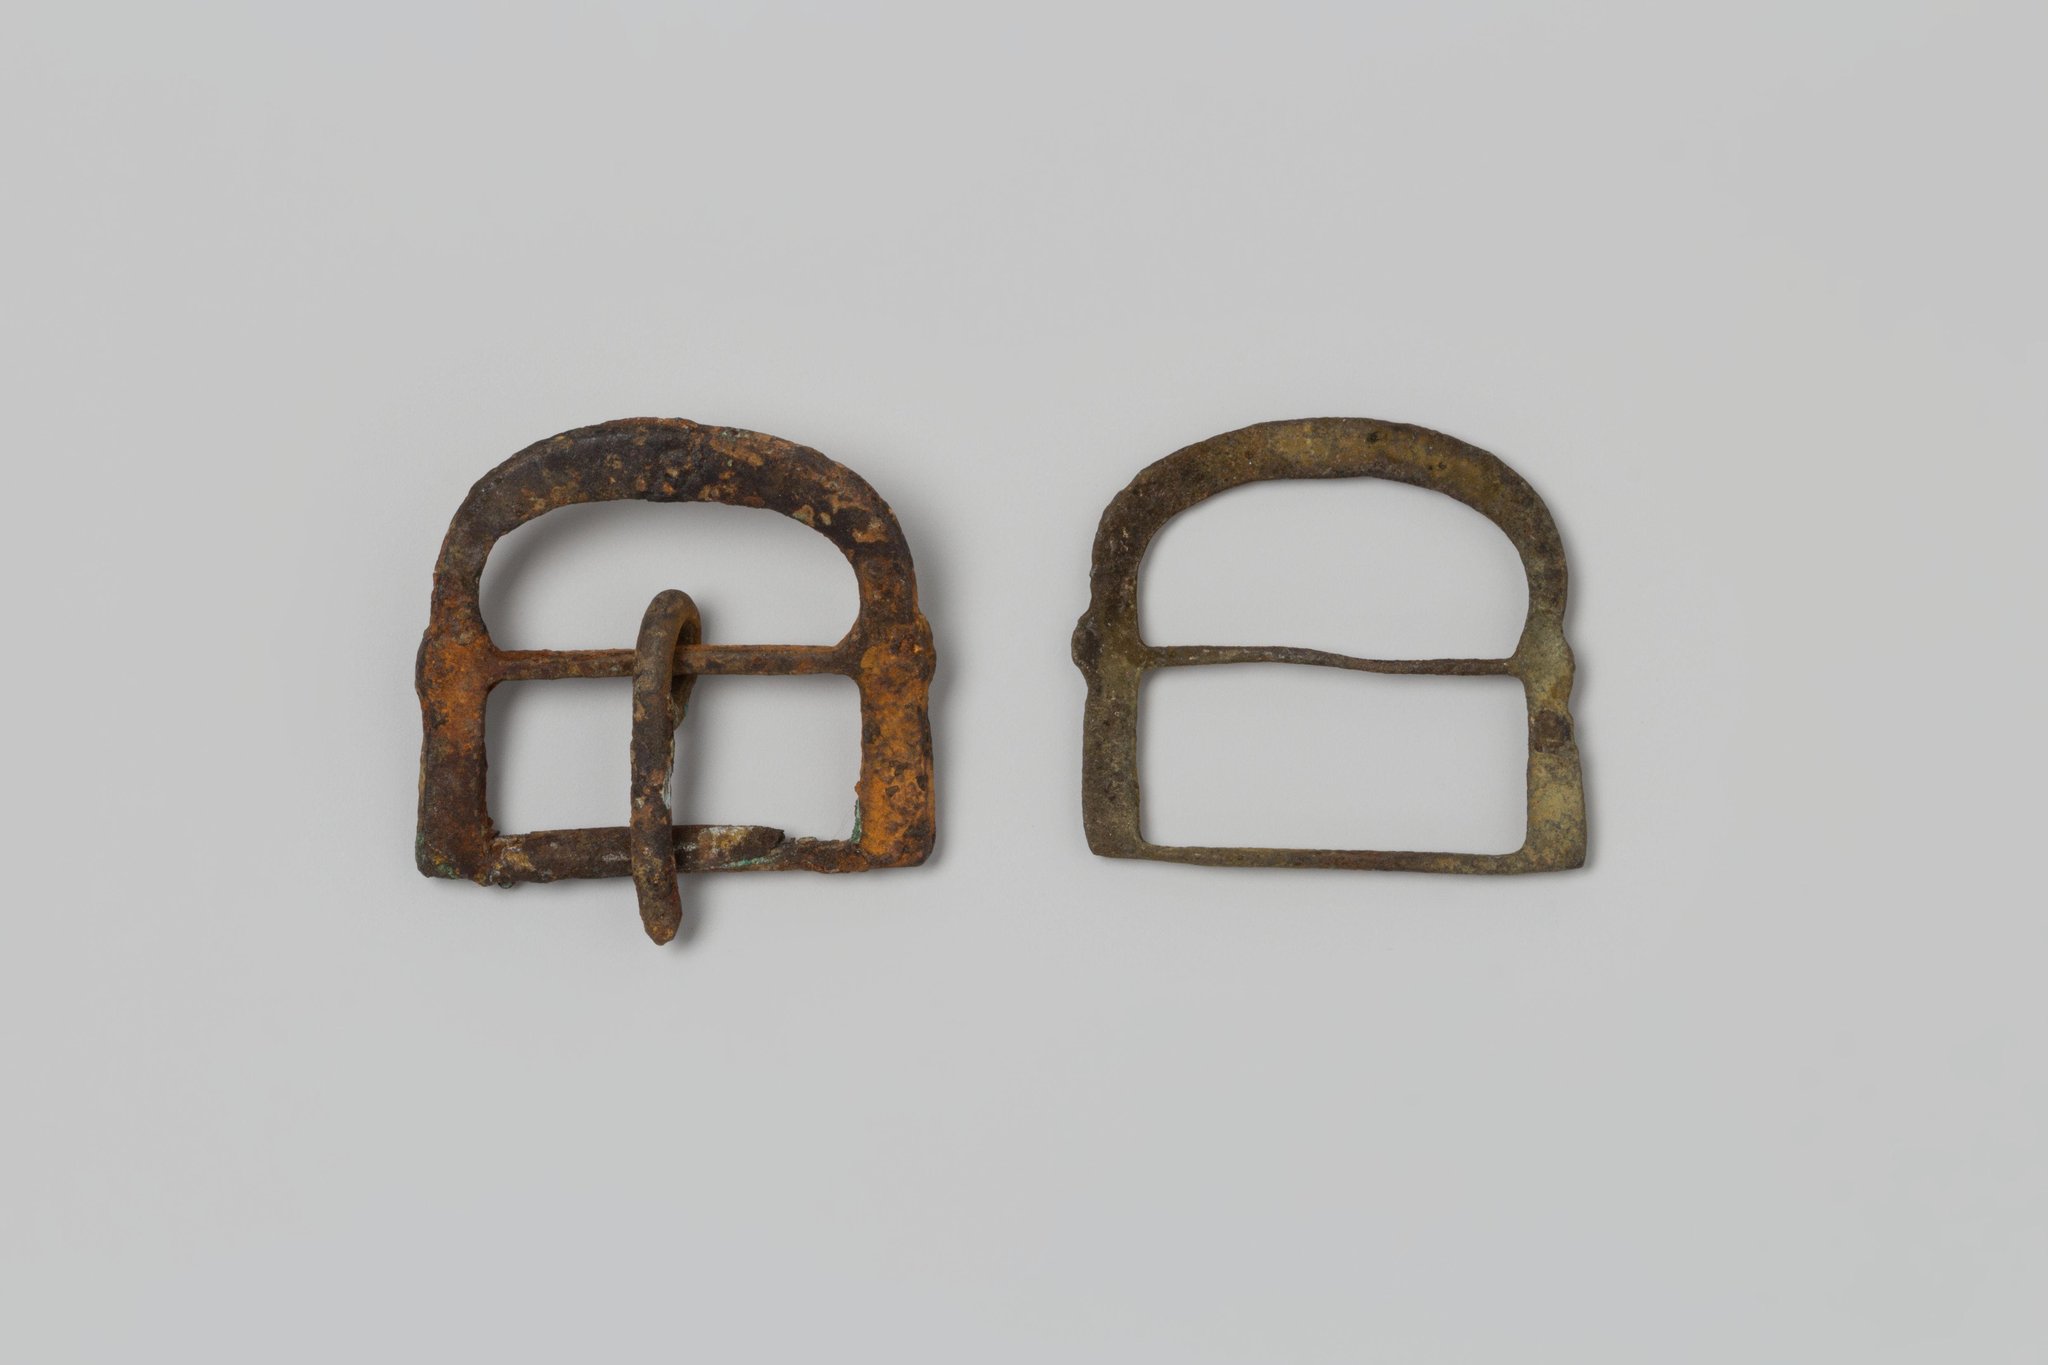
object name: belt buckle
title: Riemgesp uit het wrak van de Oost-Indiëvaarder Hollandia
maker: Anonymous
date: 1700-1743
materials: copper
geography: netherlands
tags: verenigde oostindische compagnie, hollandia (schip), annet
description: D-shaped, rings, with tongue, id. NG 1979-177H537 belt buckle.